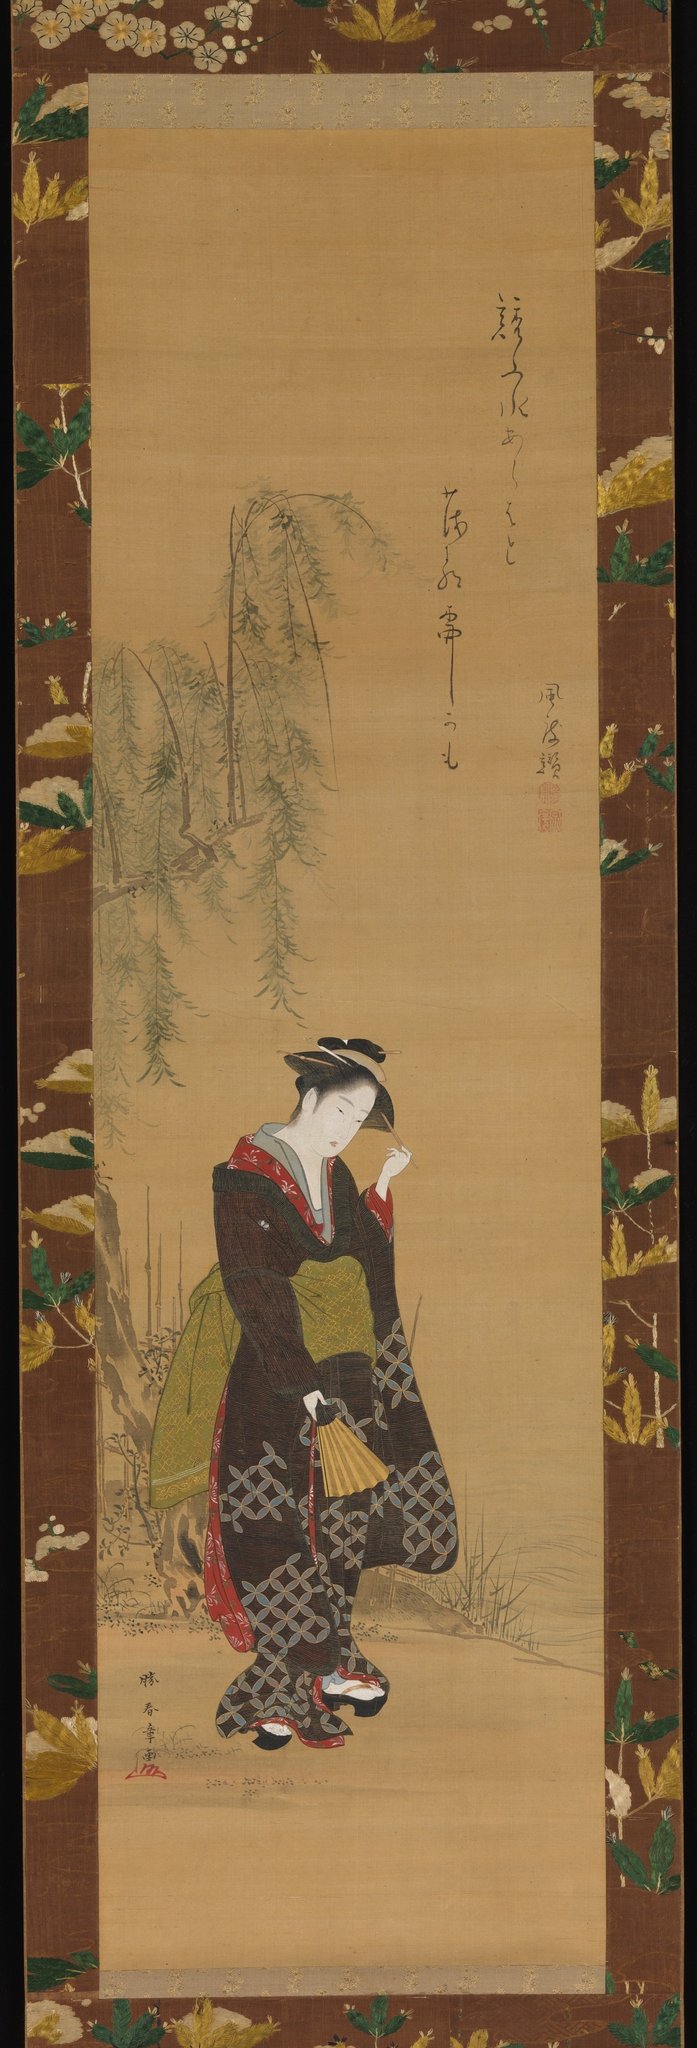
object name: hanging scroll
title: Woman under a Willow Tree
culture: japanese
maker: katsukawa shunshō 勝川春章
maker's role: artist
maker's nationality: japanese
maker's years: 1726-1792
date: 1701-1800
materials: ink, silk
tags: women